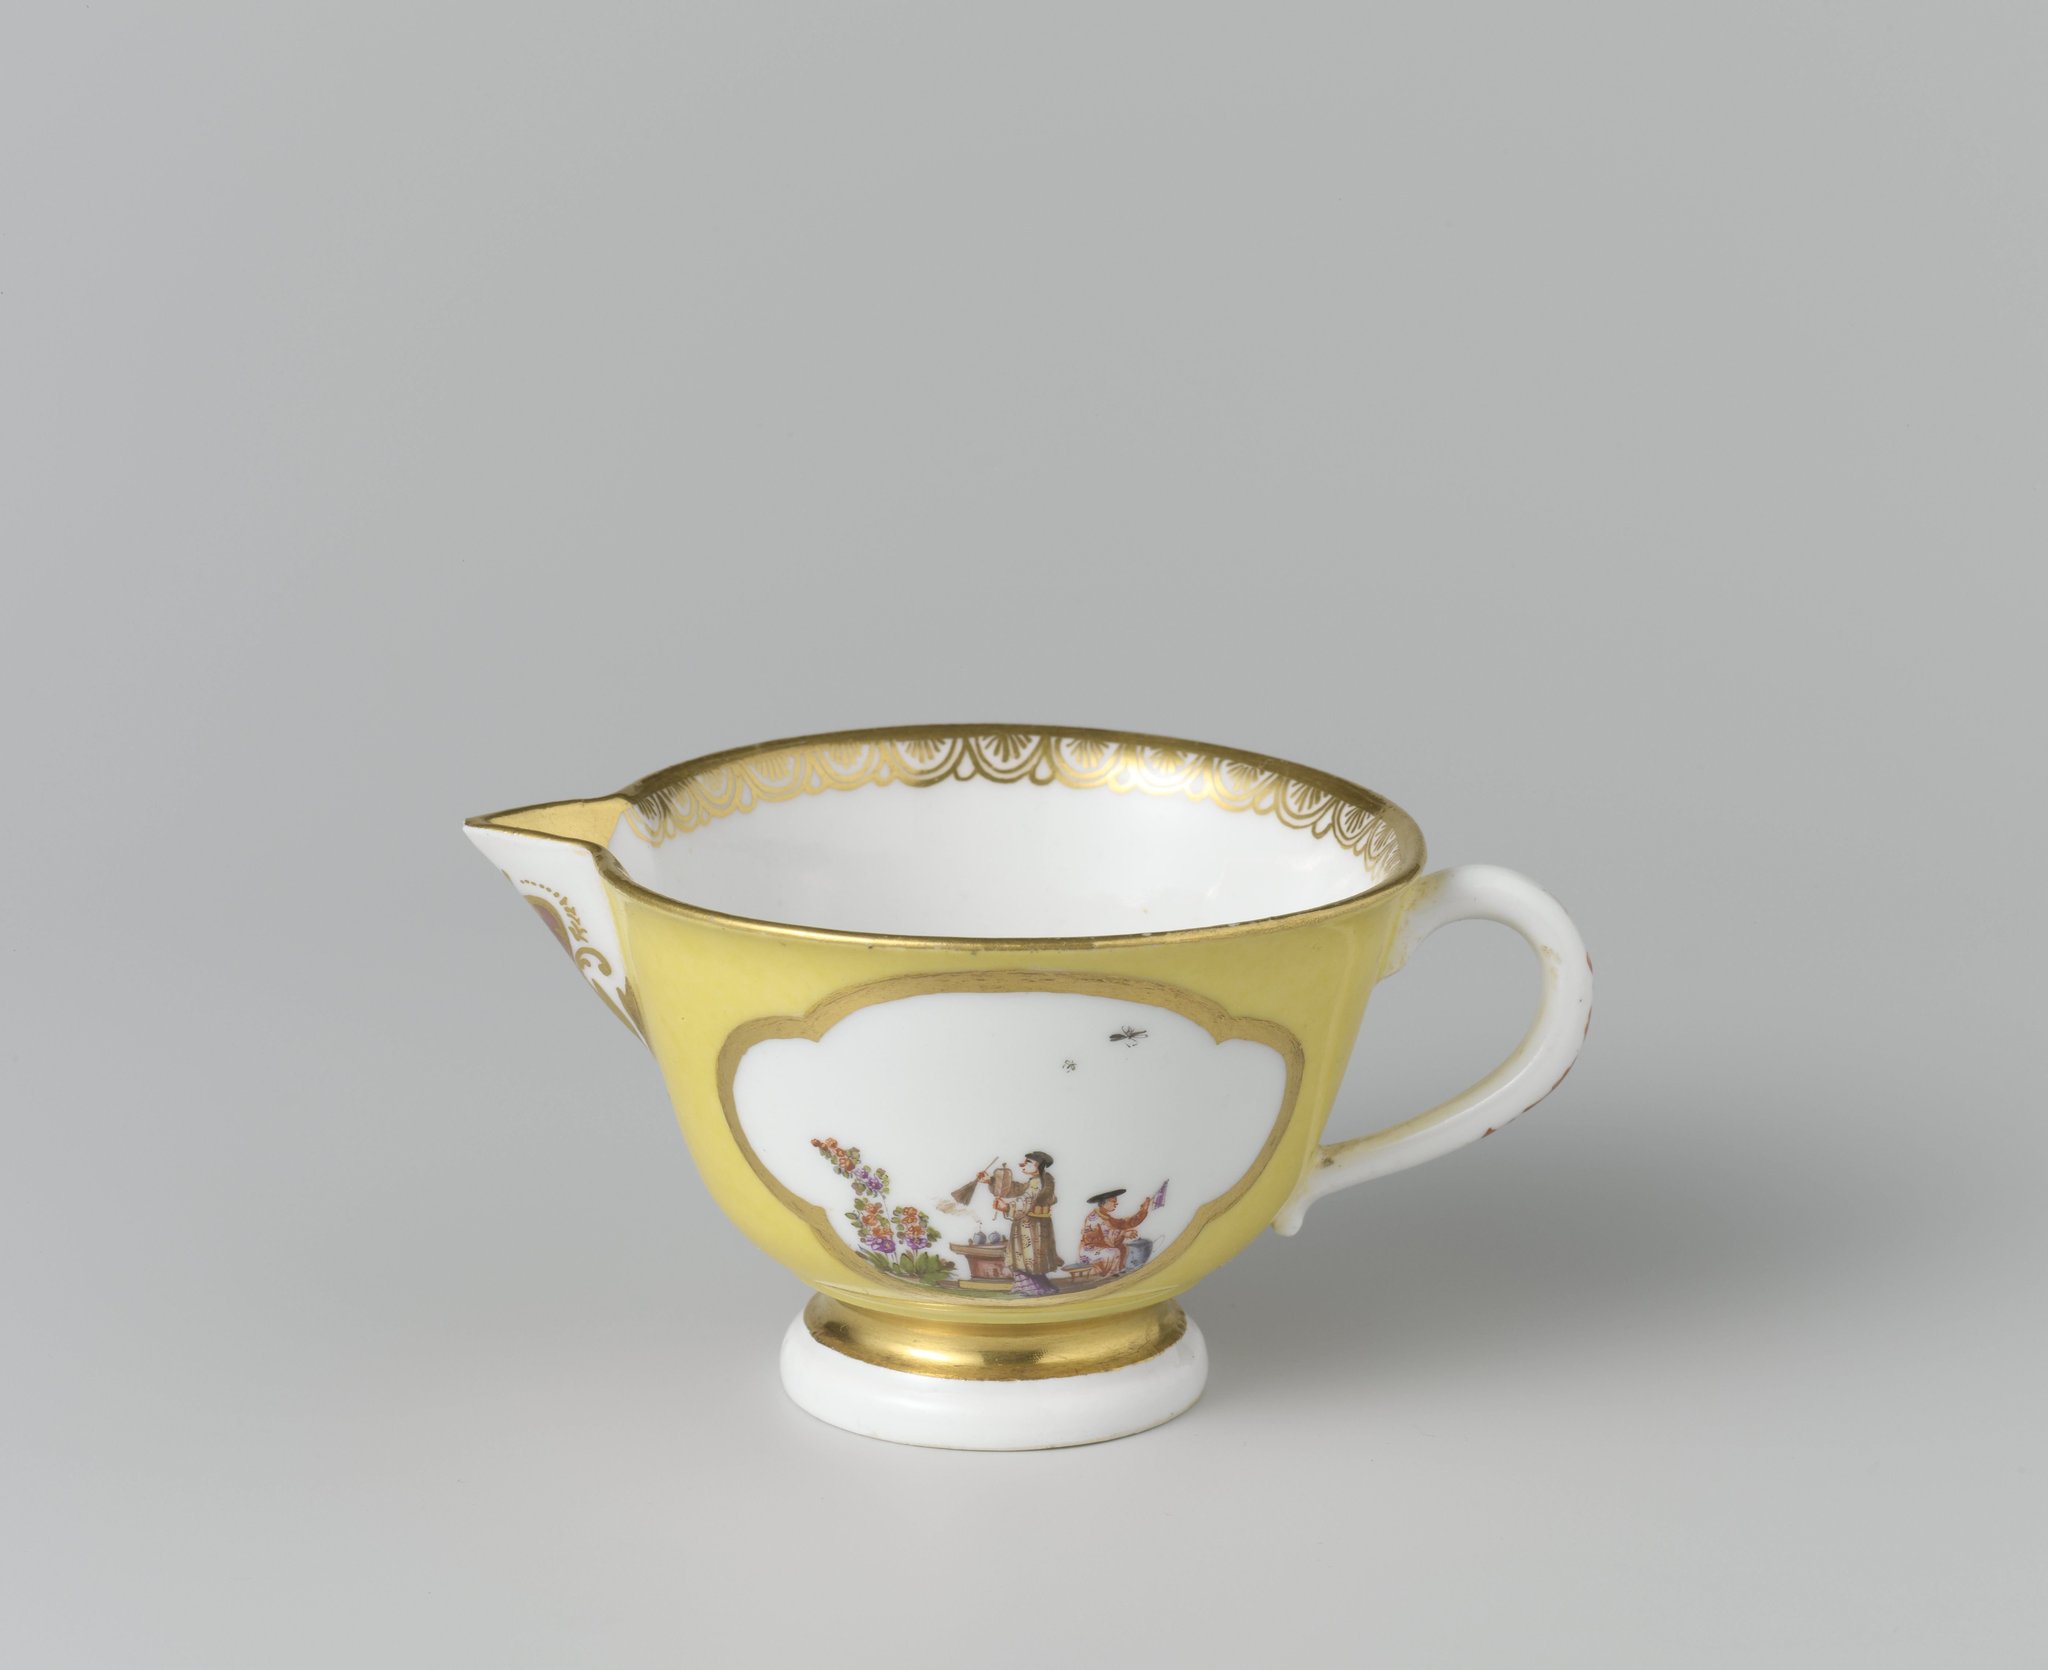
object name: eating drinking utensil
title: Spouted cup and cooling saucer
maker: johann martin kittel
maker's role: porseleinmodelleur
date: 1730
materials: porcelain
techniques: painted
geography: meissen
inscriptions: mold mark, label: ‘SAMMLUNG / Dr. FRANZ OPPENHEIMER’, number: ‘216.’, factory mark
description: Hot beverages, such as coffee, were sometimes drunk in a curious fashion during the 18th century, namely from a saucer! The coffee was poured from the spouted cup into the saucer to cool more quickly. The chinoiserie decorations and the yellow background are typical of Johann Gregorius Höroldt’s designs.